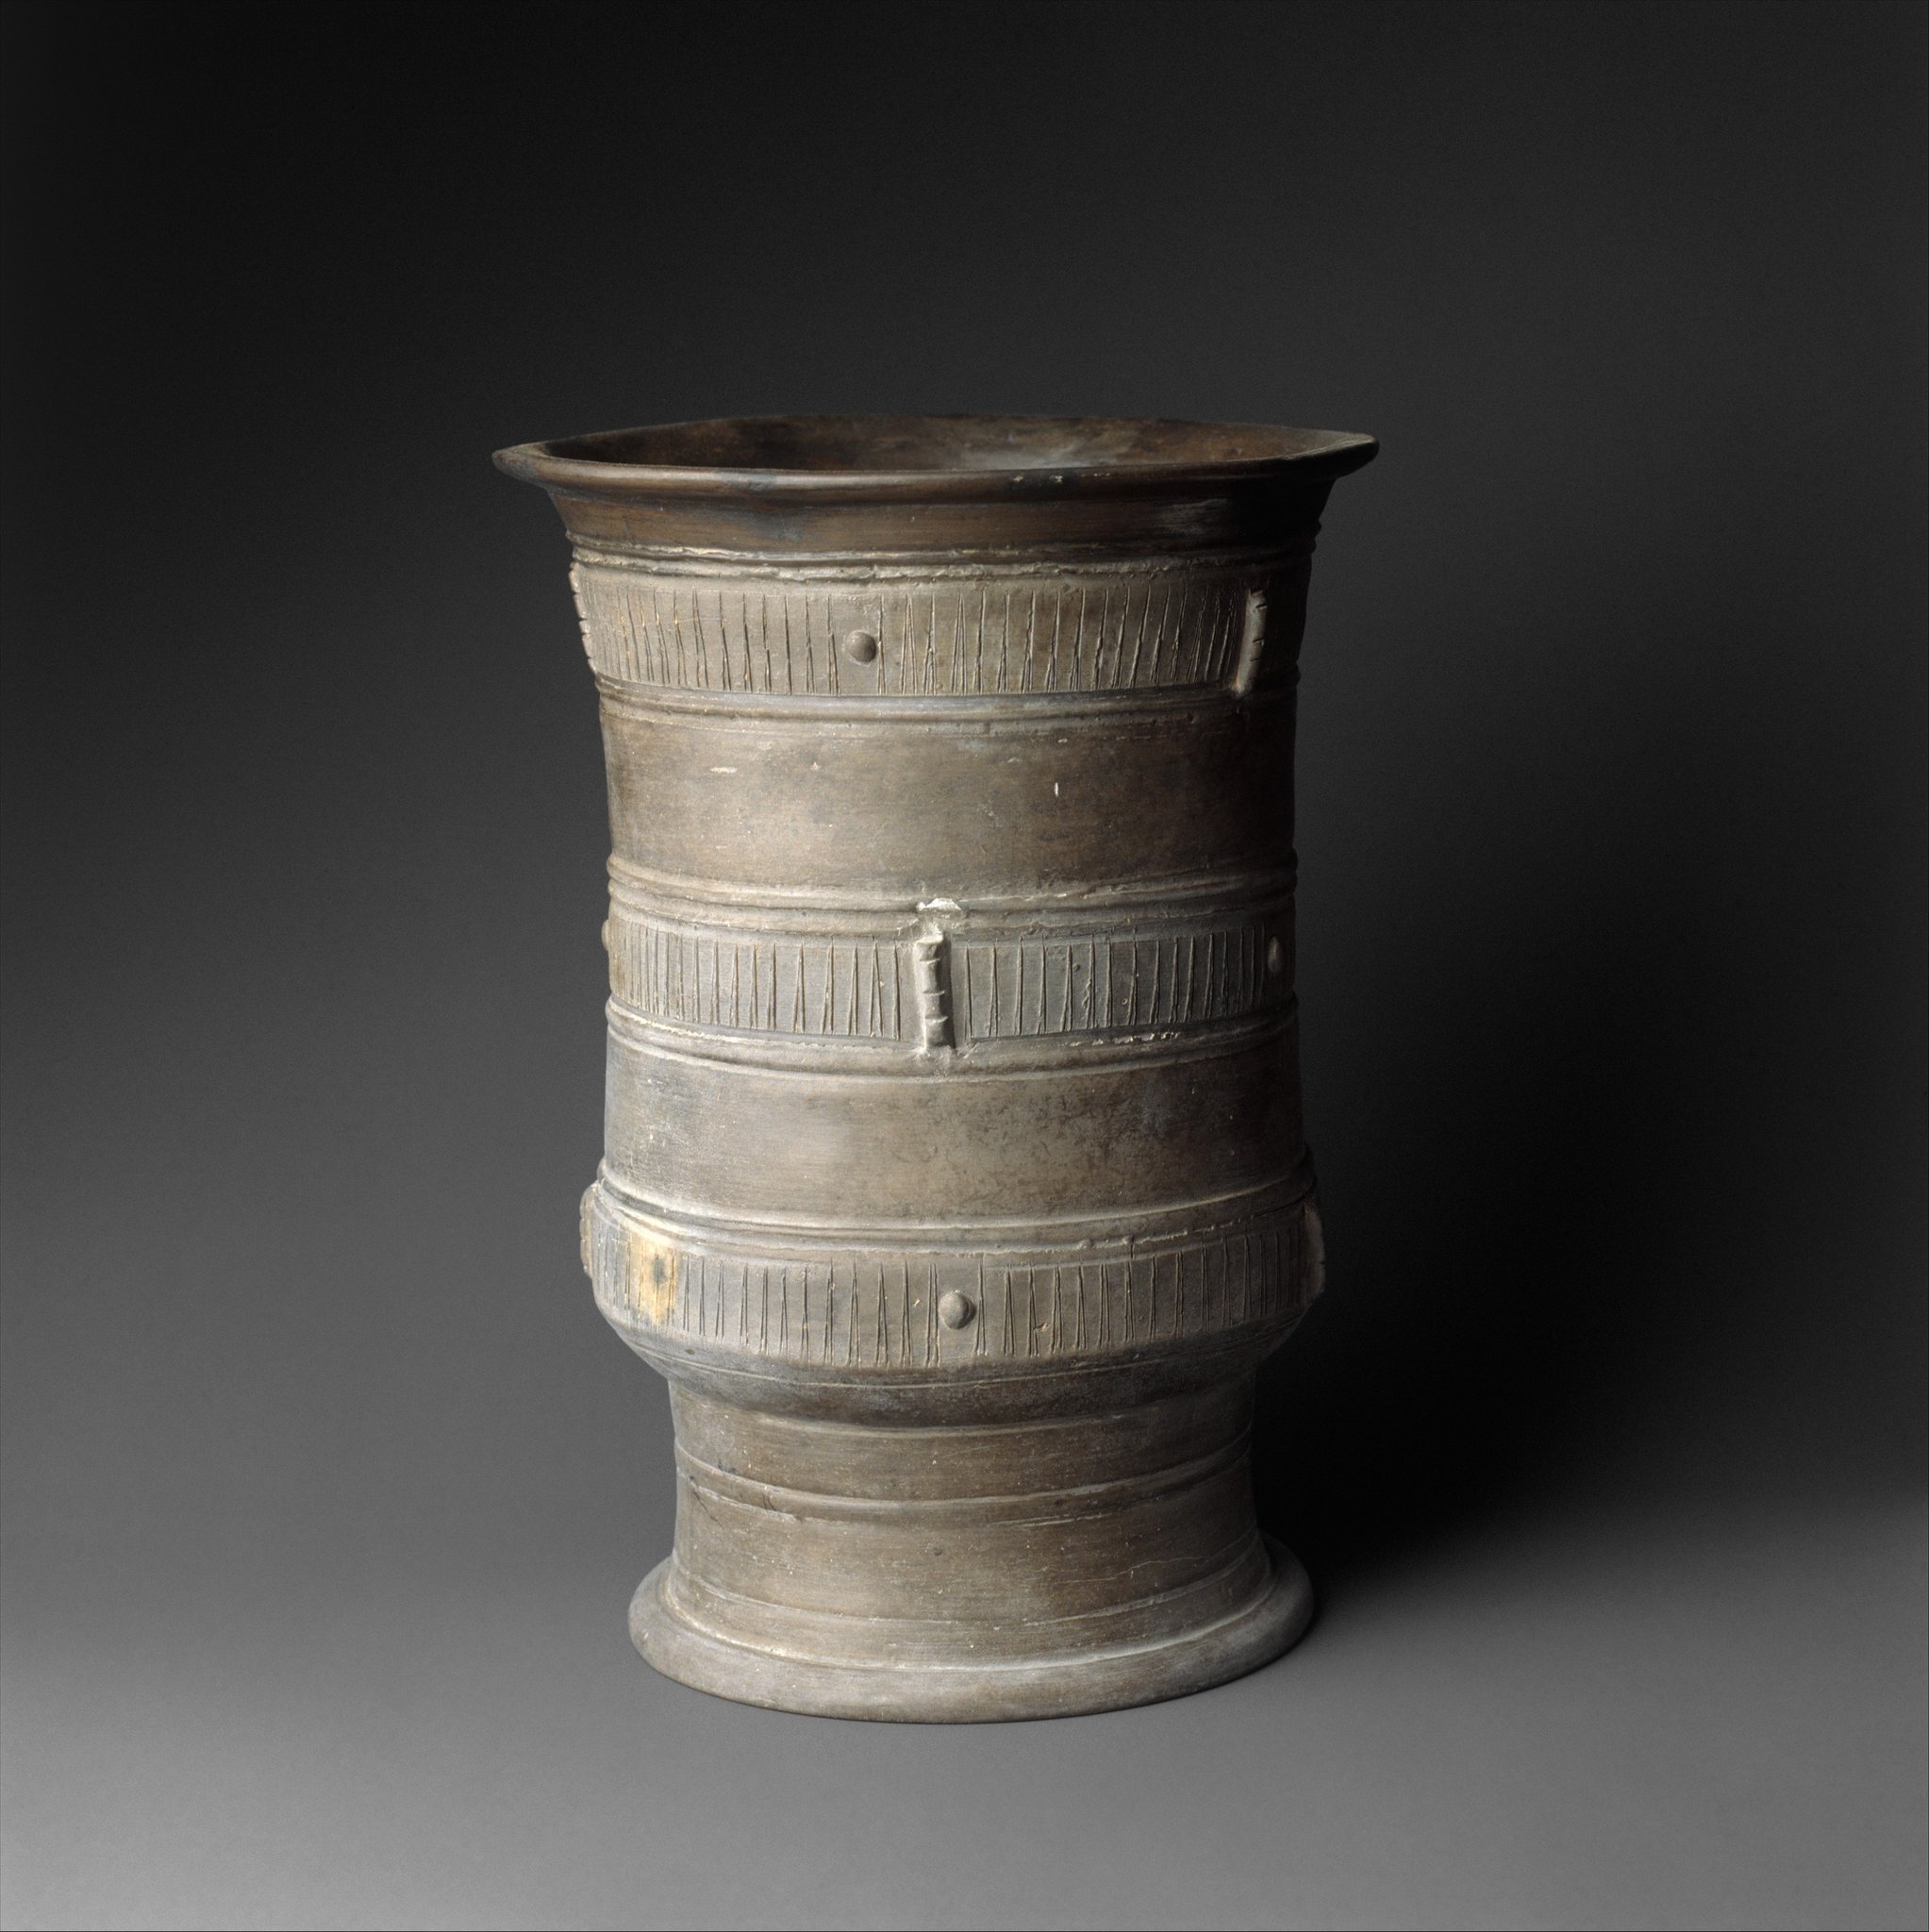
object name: jar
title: Jar (Zun)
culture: chinese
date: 1300-1001 BCE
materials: earthenware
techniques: incising